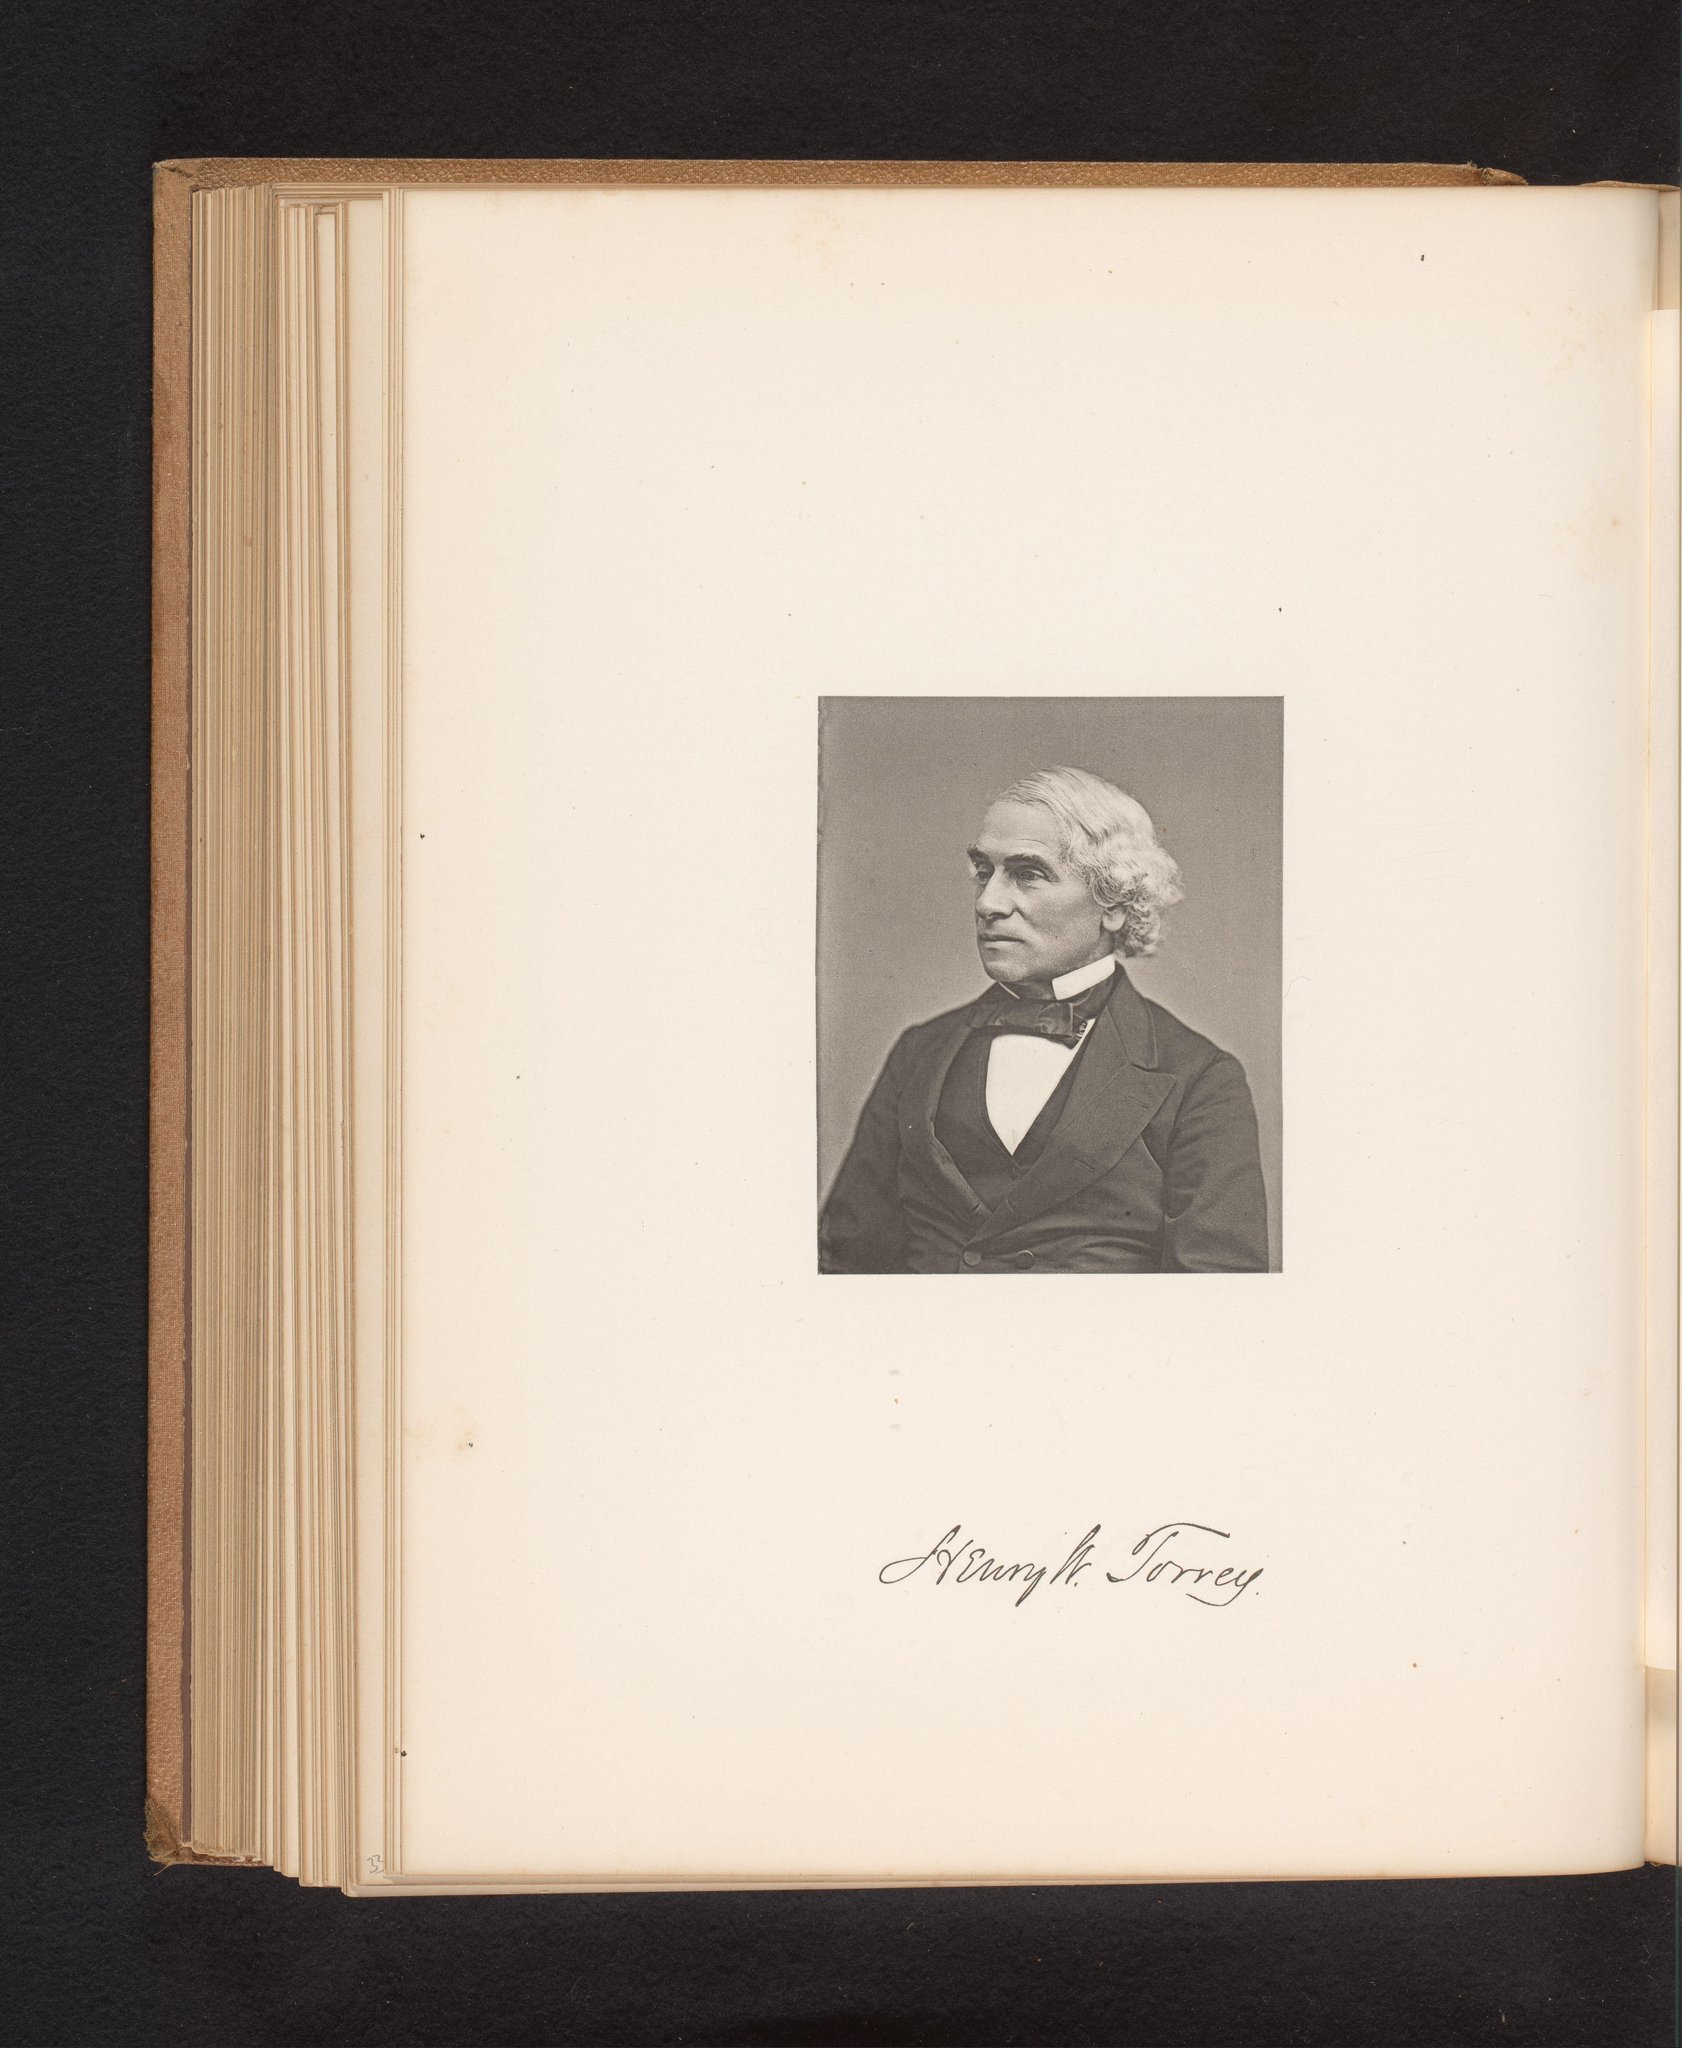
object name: photomechanical print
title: Portret van Henry Warren Torrey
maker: Anonymous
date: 1870-1875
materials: paper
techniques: photograph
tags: historical persons, professor